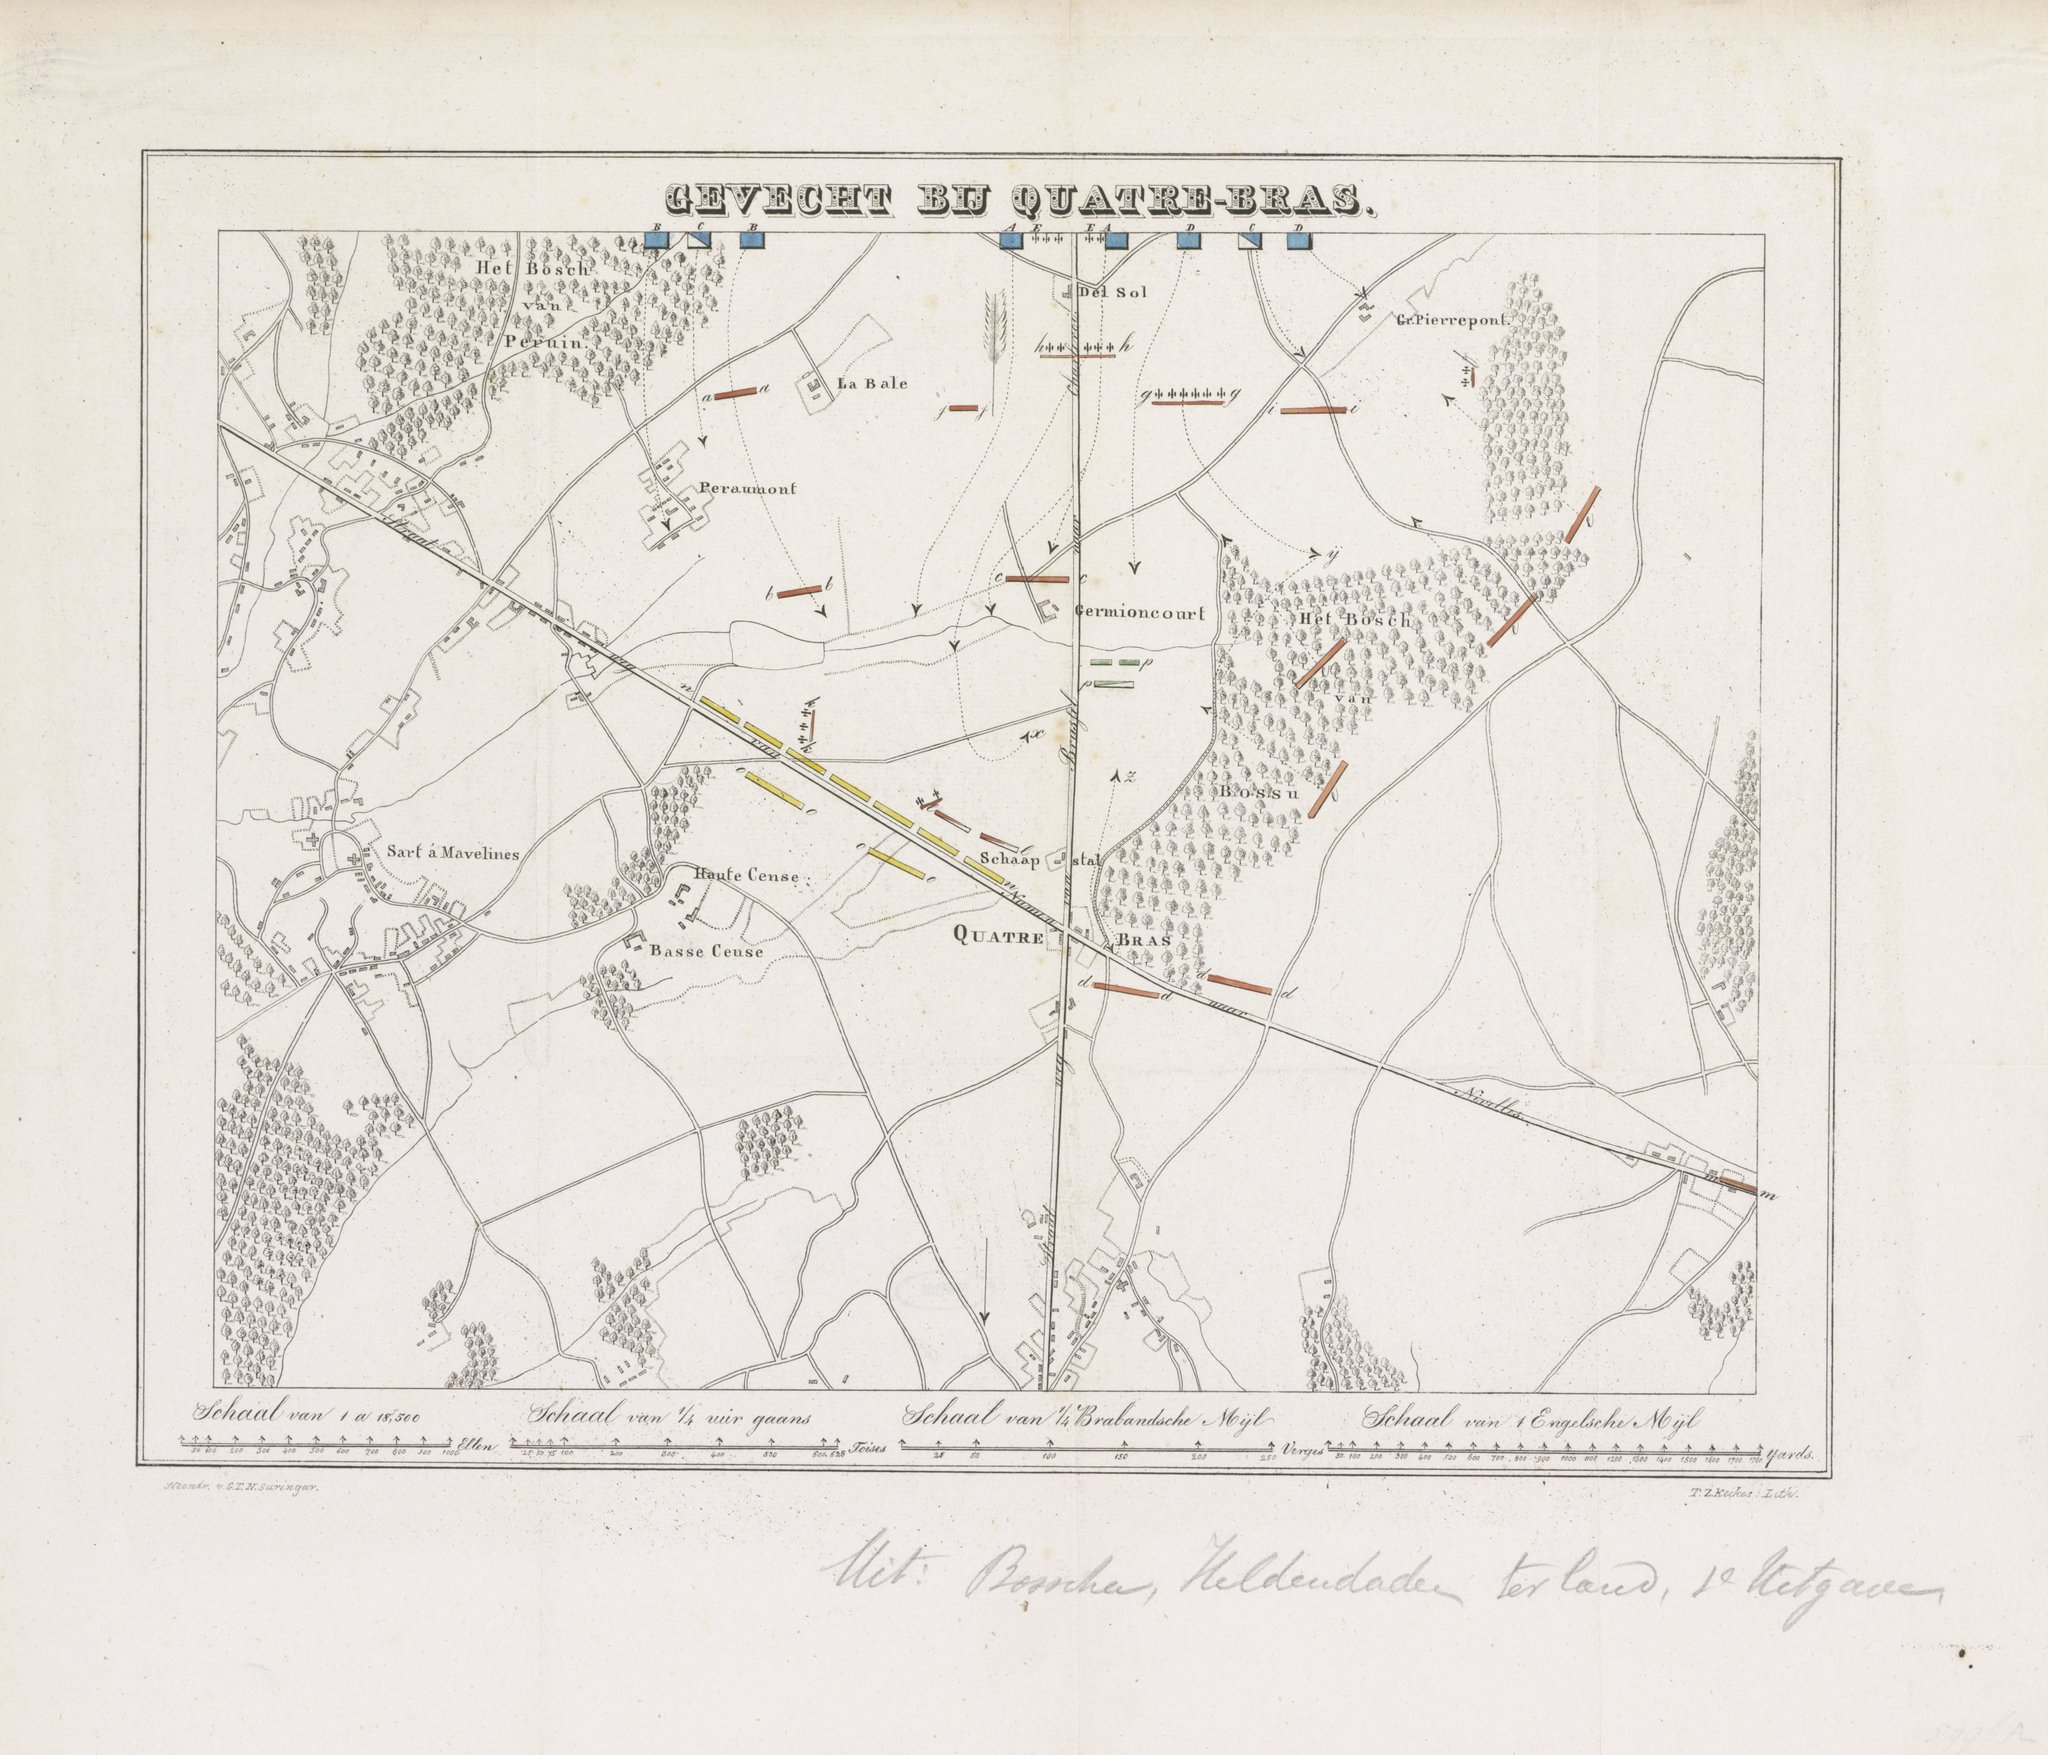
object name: map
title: Gevecht bij Quatre-Bras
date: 1832-1856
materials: paper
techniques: lithograph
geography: leeuwarden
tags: maps of separate countries or regions, battle (+ land forces), battle arrays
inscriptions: collector's mark: Lugt 2228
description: Gebruikt als illustratie in: Johannes Bosscha, Neêrlands heldendaden te land, van de vroegste tijden af tot in onze dagen. Leeuwarden : Suringar, 1834-1856. Niet in Frederik Muller; door het RPK toegevoegd nummer.